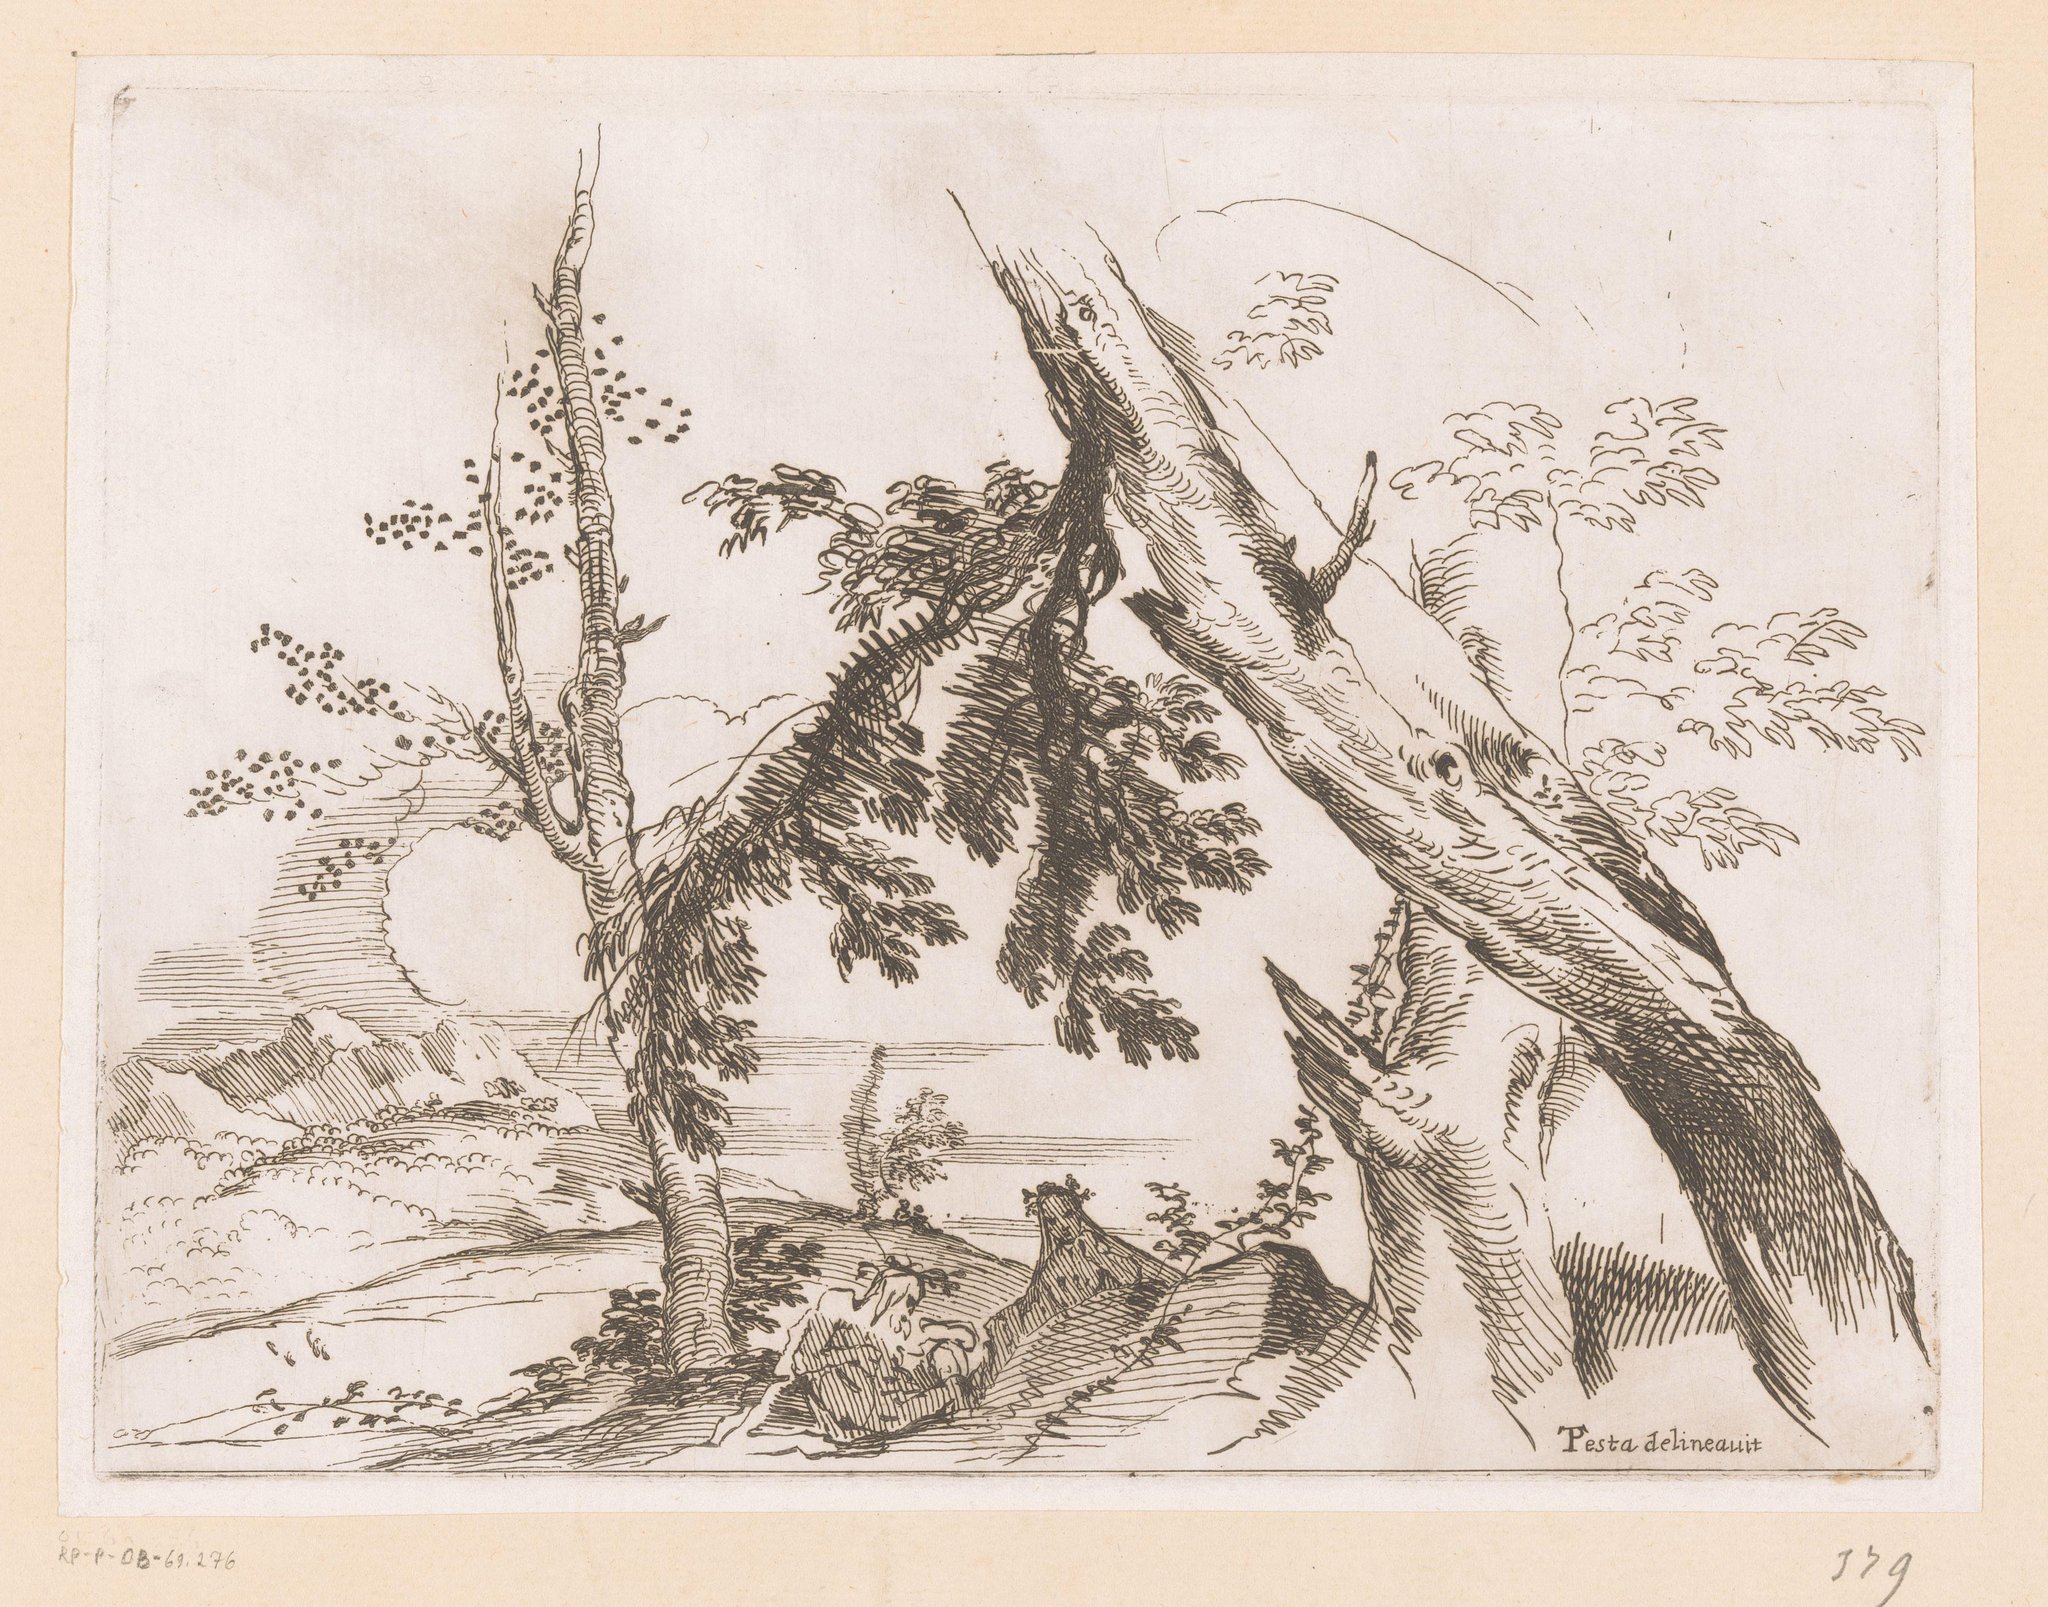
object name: print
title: Landschap met twee figuren rustend onder enkele bomen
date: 1711-1765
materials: paper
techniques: etching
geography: france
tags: trees, resting - bb - out of doors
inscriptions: collector's mark: Lugt 240